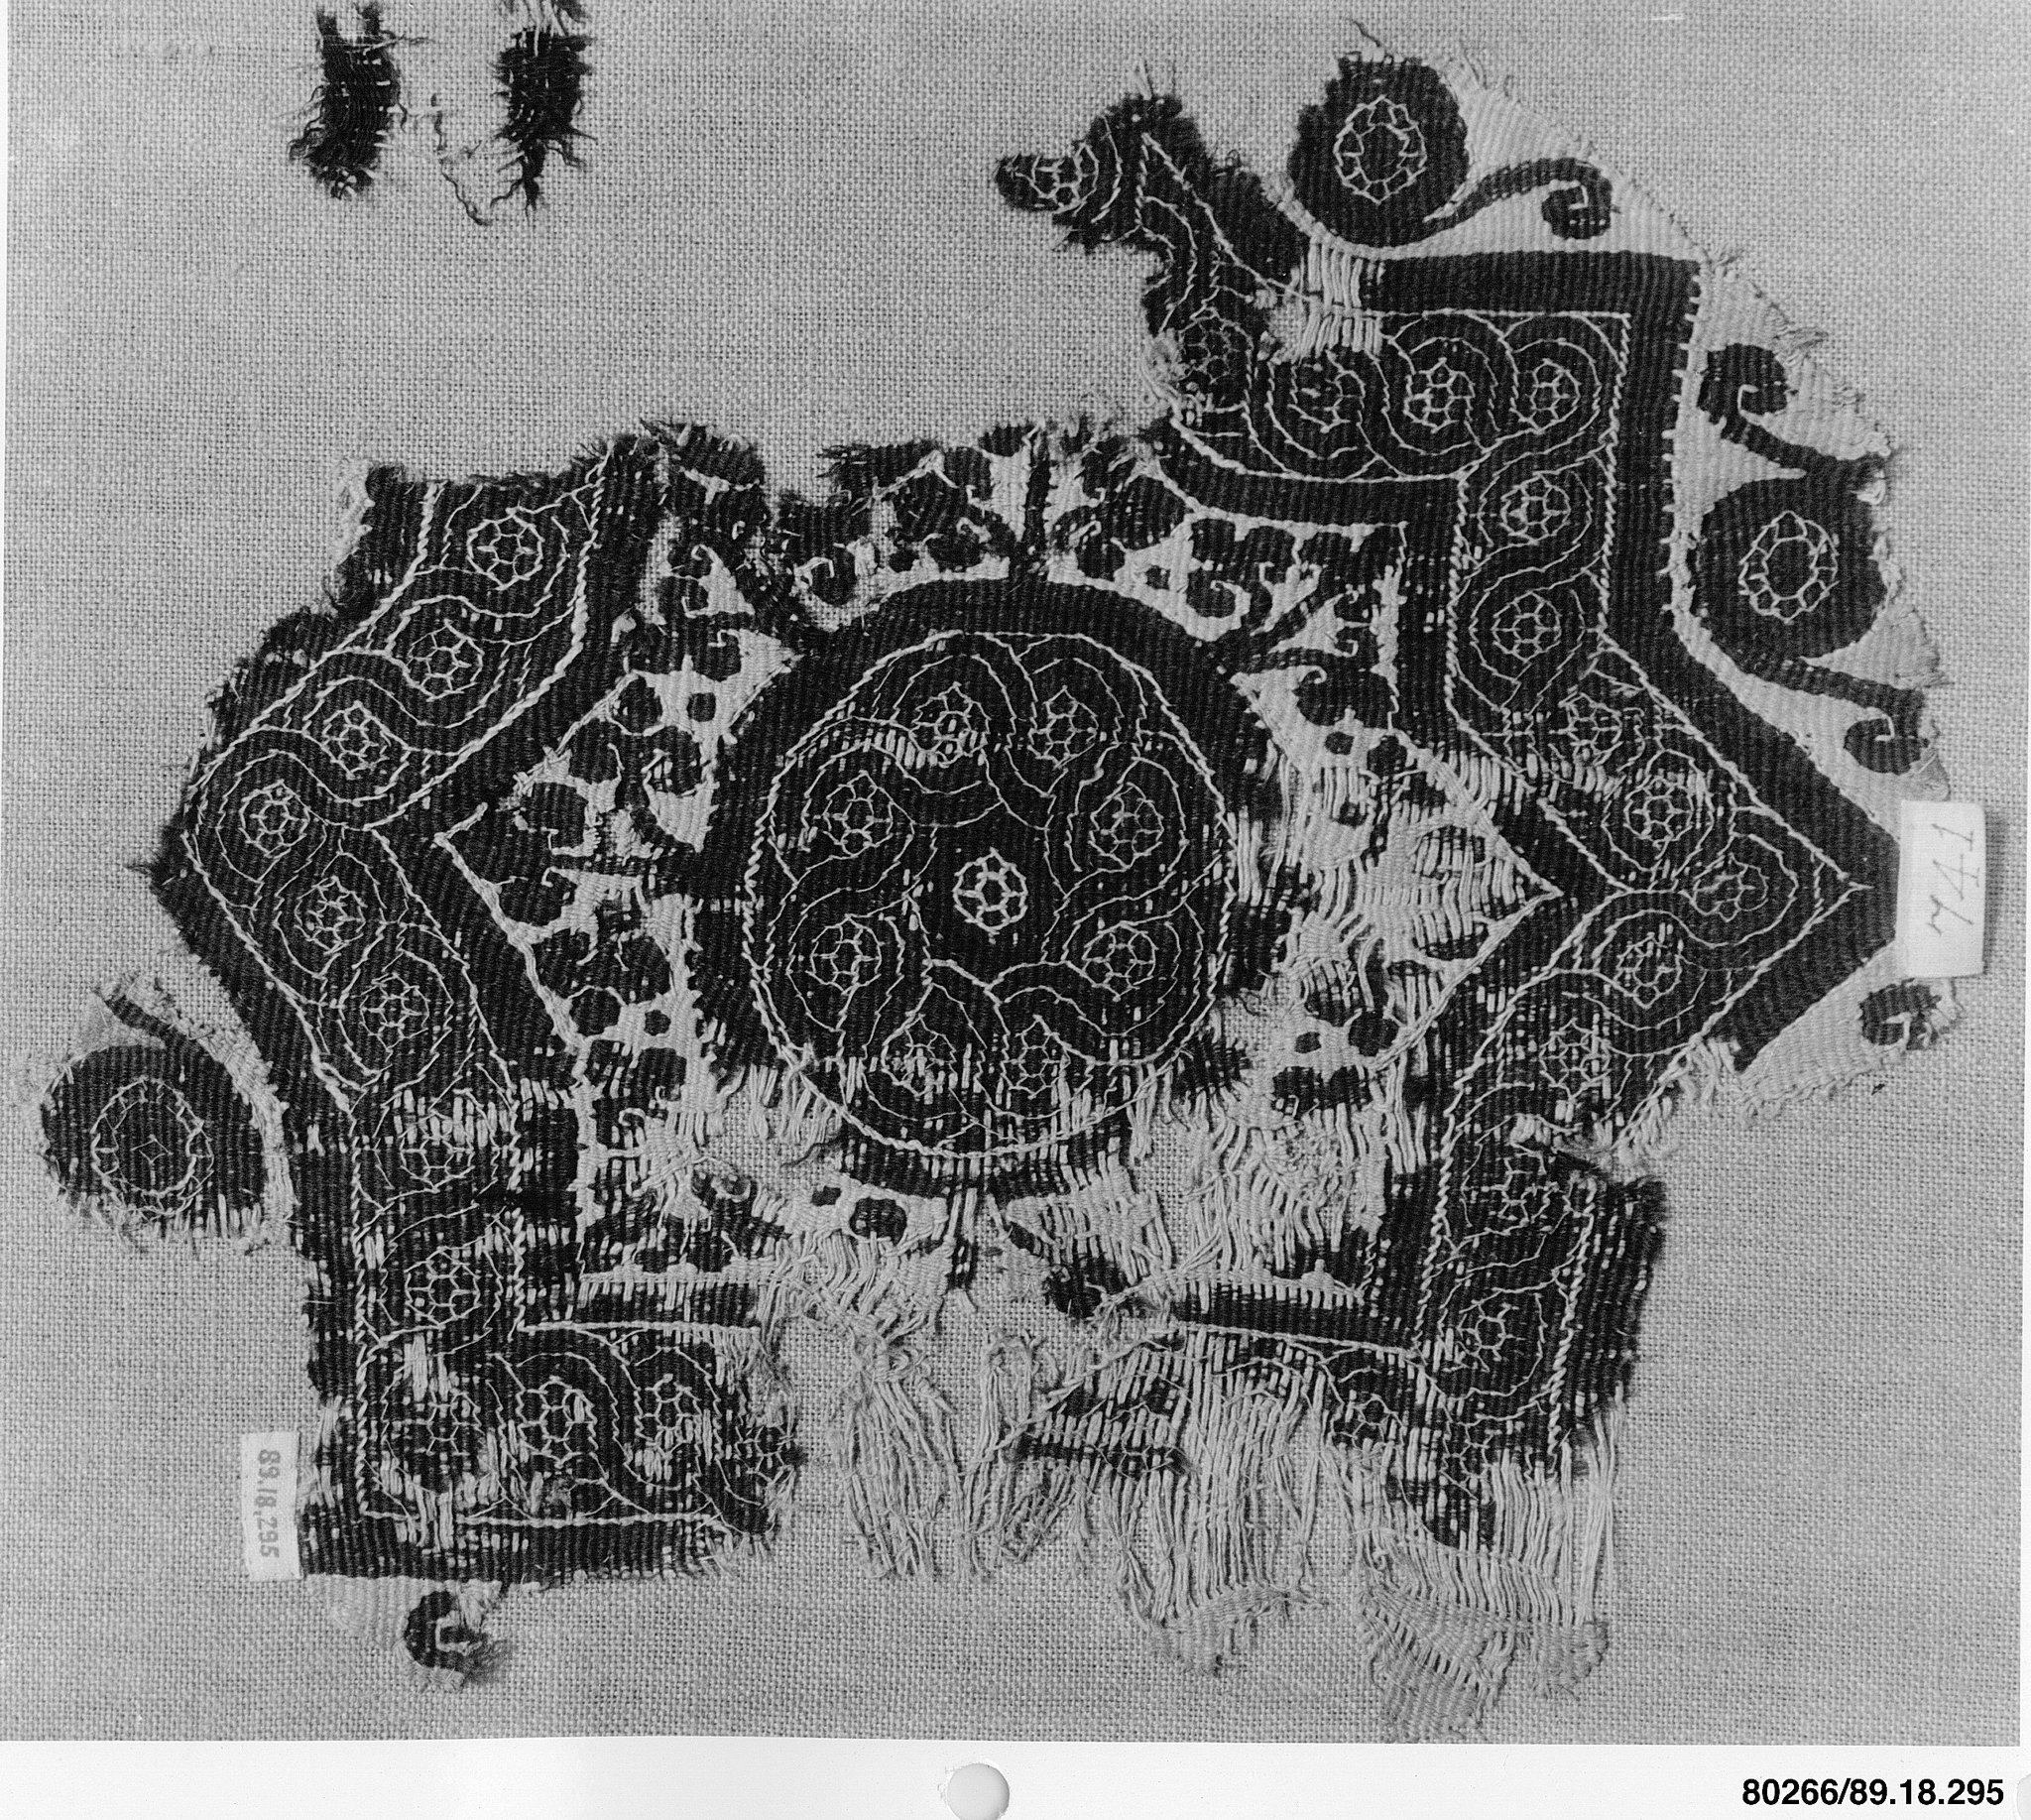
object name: textile fragment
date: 201-400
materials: linen, wool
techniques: weave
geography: egypt